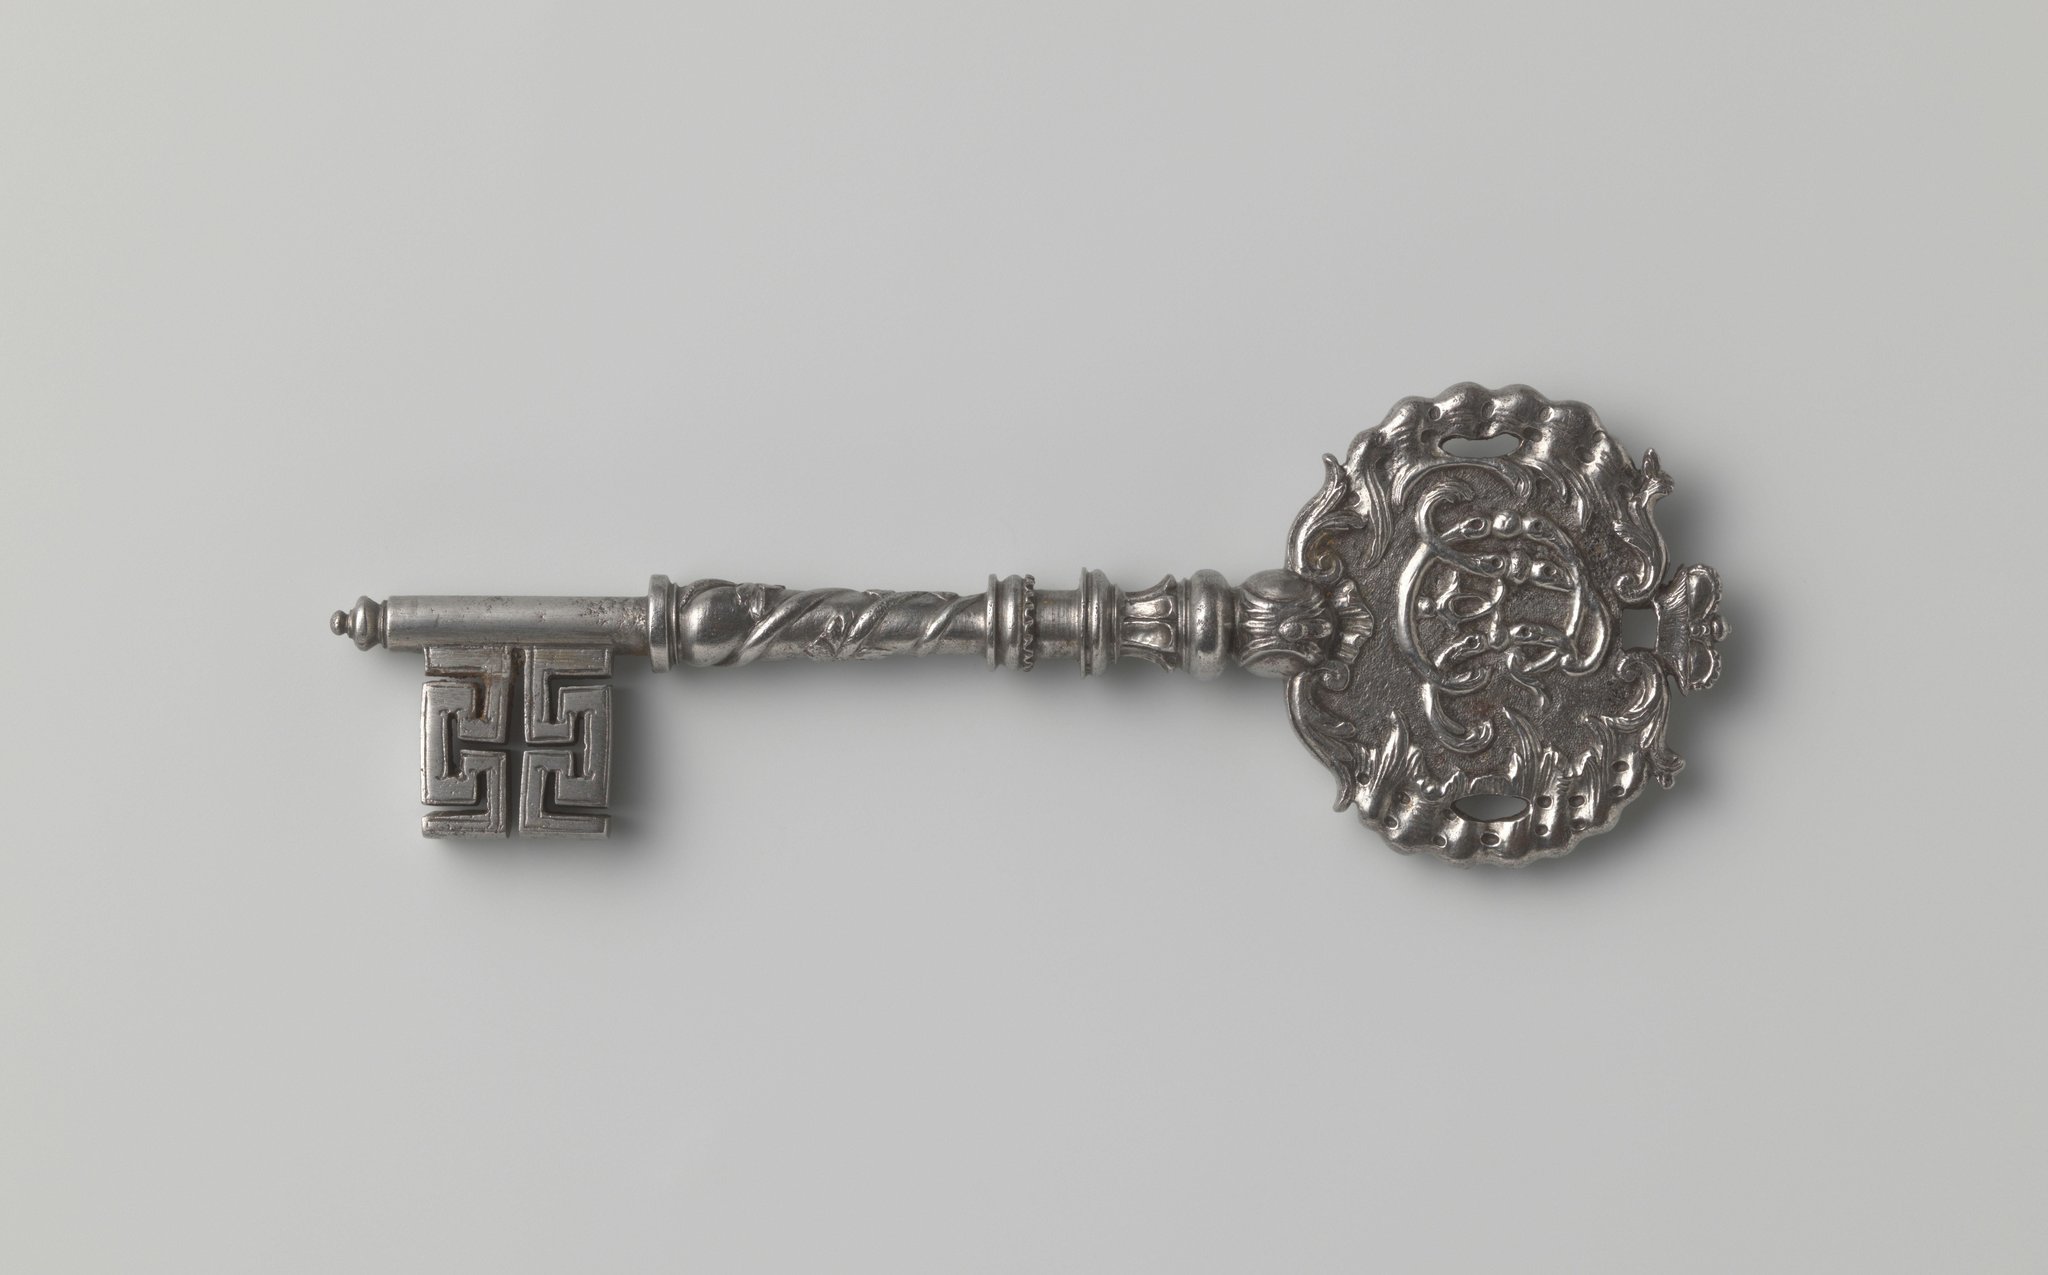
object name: key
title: Sleutel van smeedijzer met wapen en monogram CA van Clemens August von Bayern, keurvorst en aartsbisschop van Keulen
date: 1750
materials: iron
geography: germany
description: Sleutel van smeedijzer met wapen en monogram CA van Clemens August von Bayern (1723-1761), keurvorst en aartsbisschop van Keulen. Om de gesloten pijp slingert zich een rank en de tweeledige baard is meandervormig ingesneden.